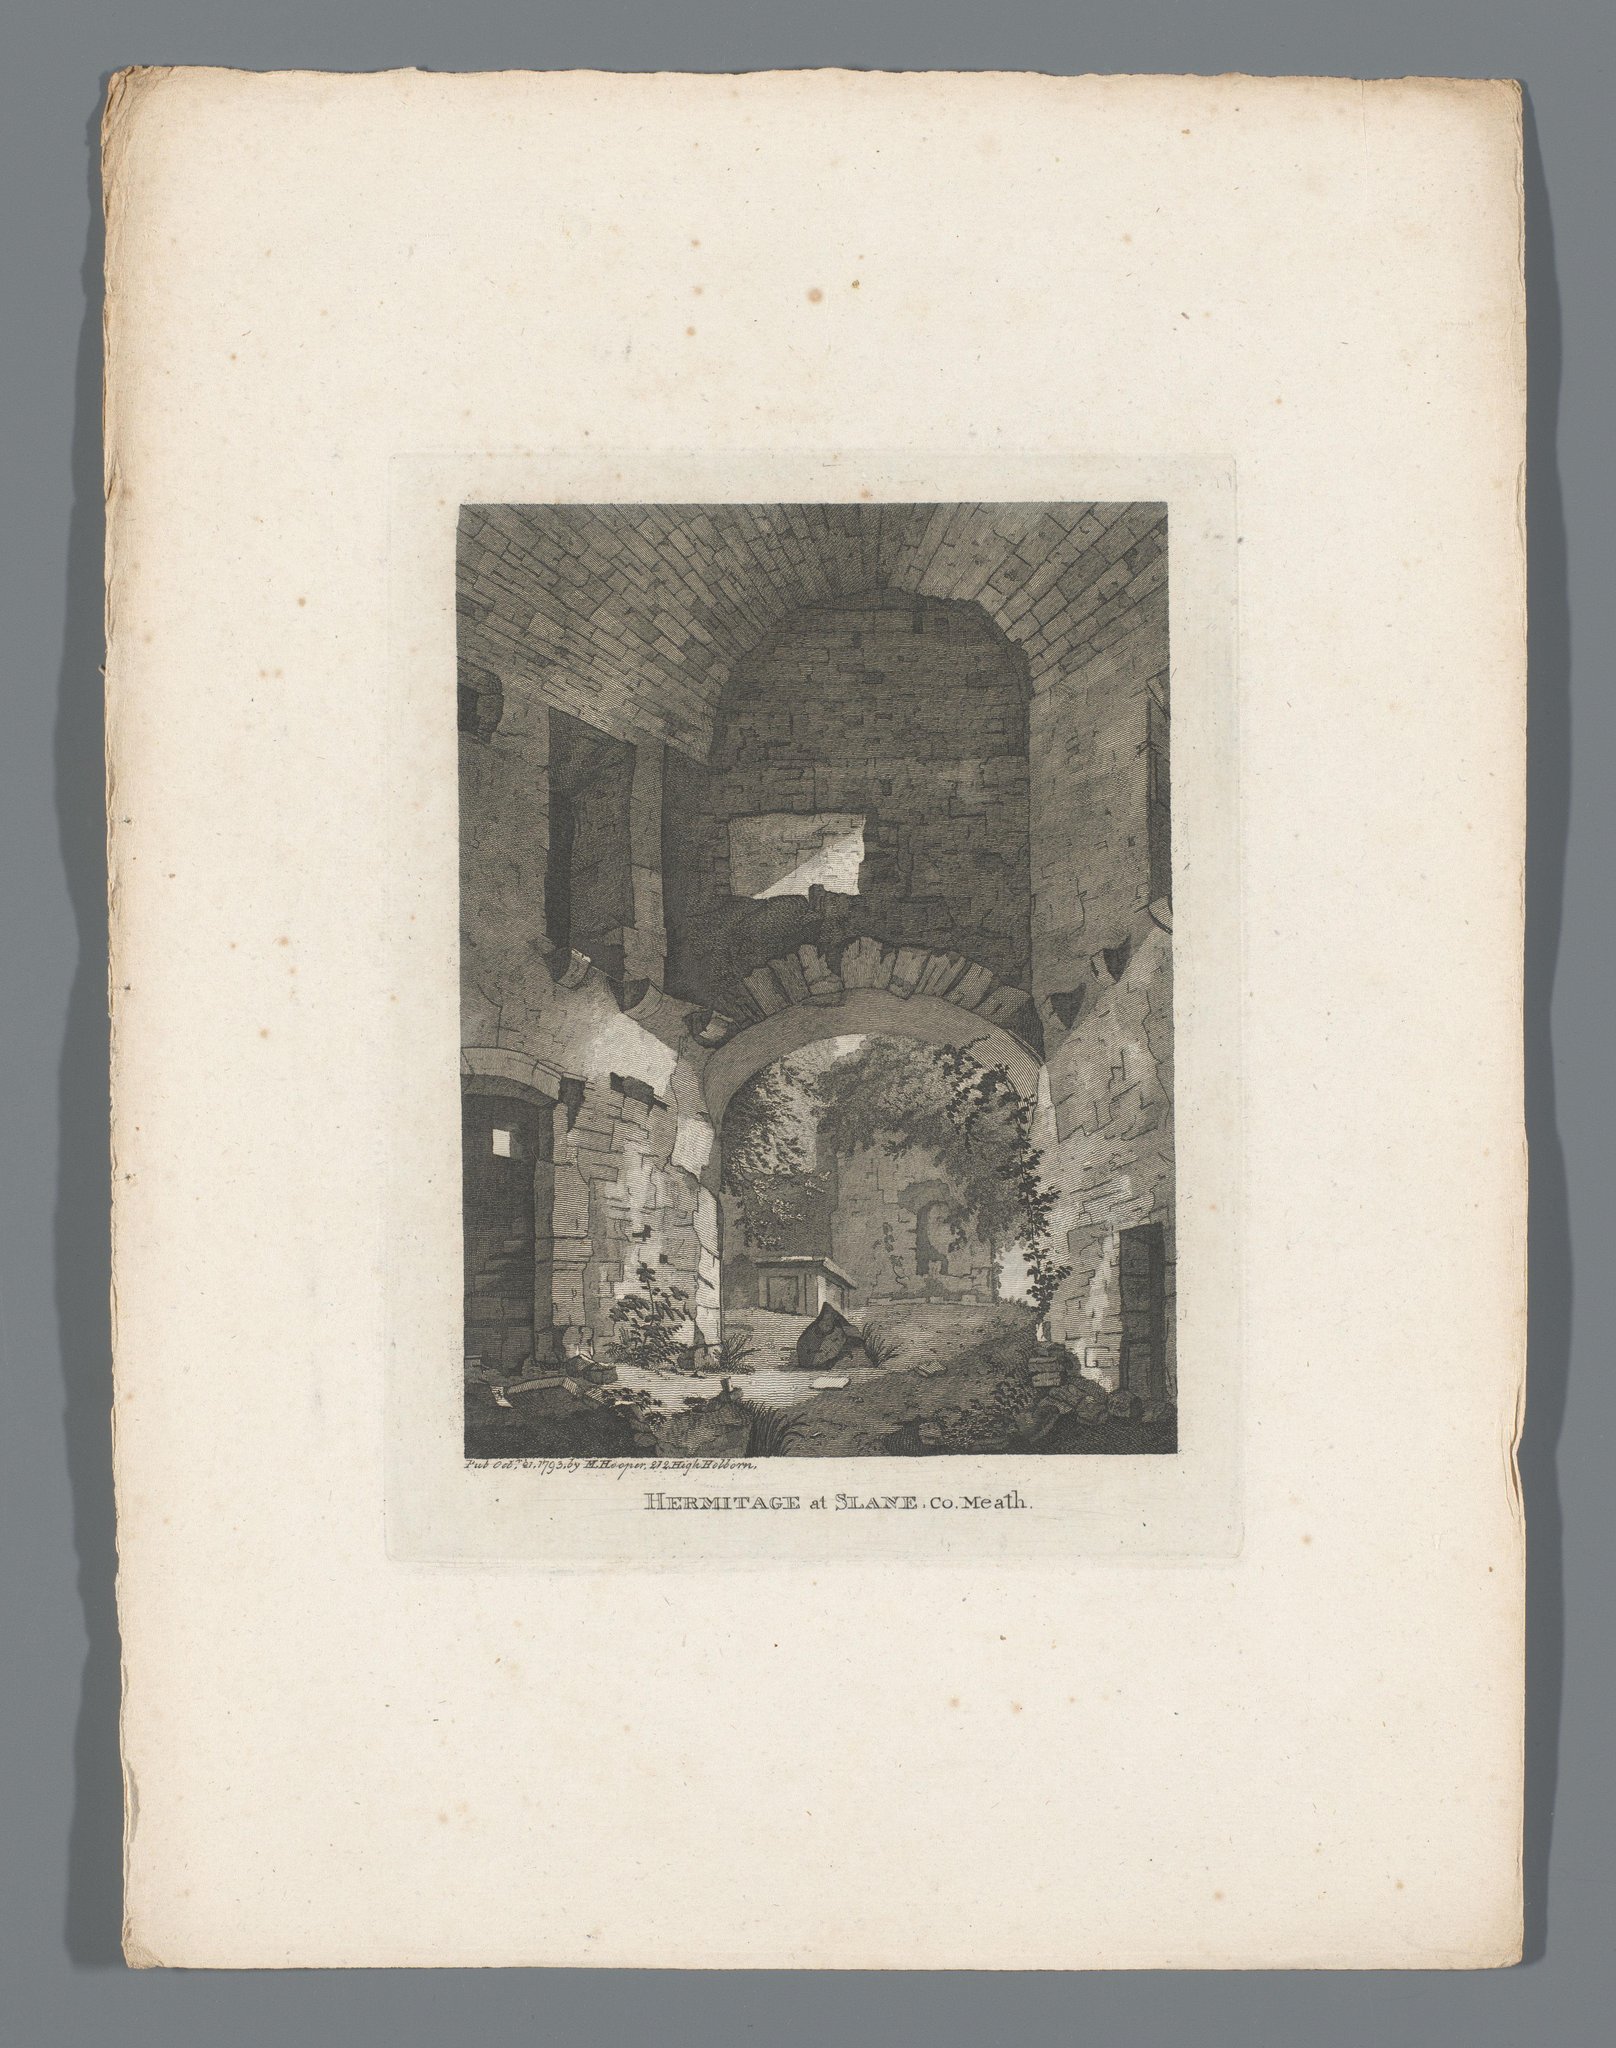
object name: print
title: Gezicht op de ruïnes van de Hermitage in Slane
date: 1793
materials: paper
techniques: etching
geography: london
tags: city-view, and landscape with man-made constructions, landscape with ruins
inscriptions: date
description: Prent verschenen in: Grose, Francis. The antiquities of Ireland, dl. 2. Londen: S. Hooper, 1795.